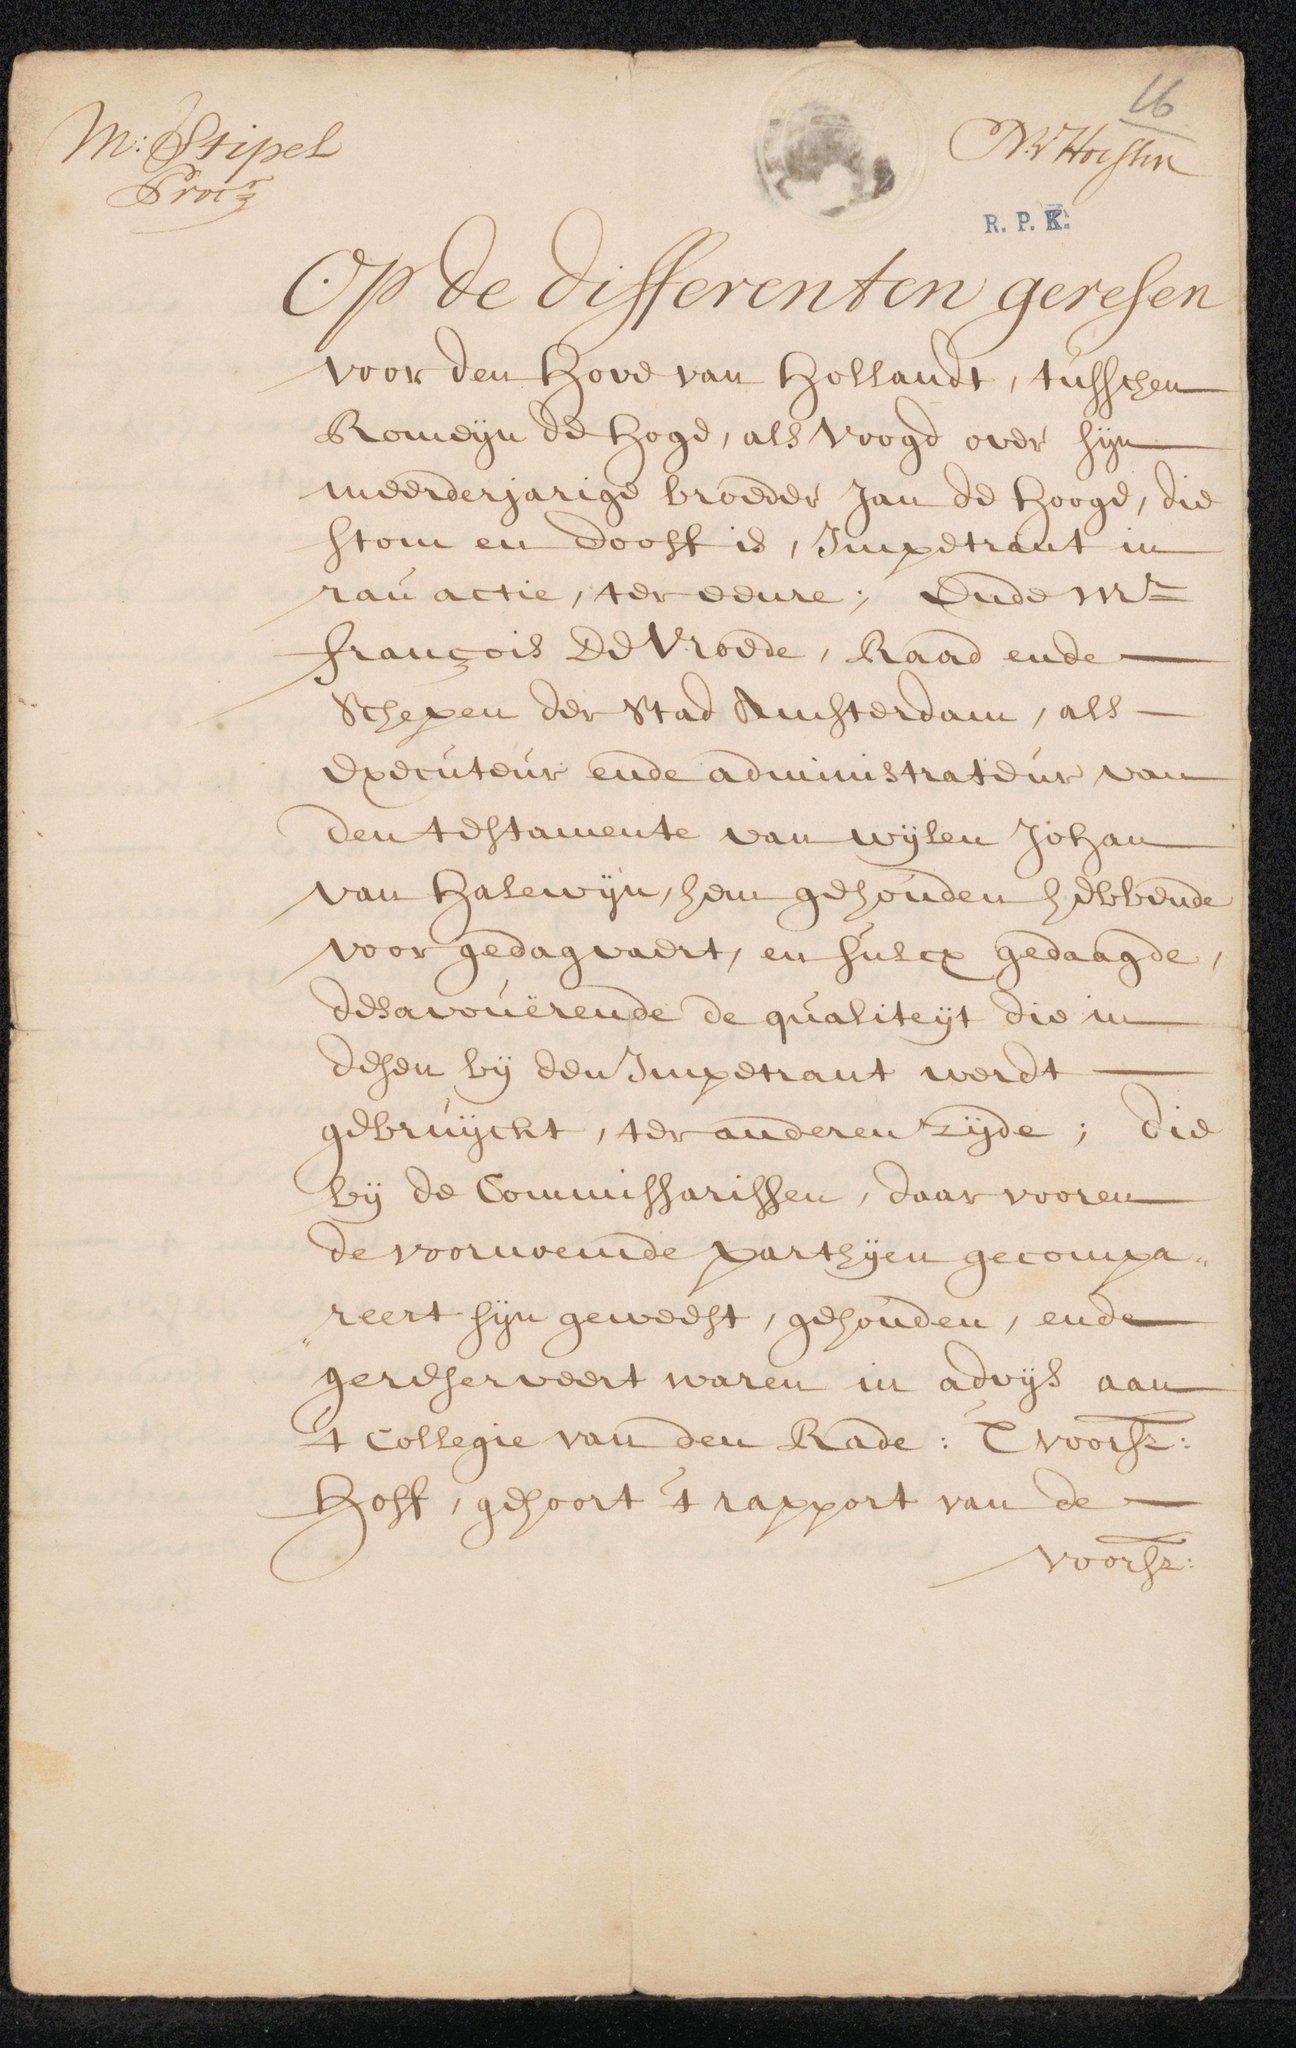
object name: manuscript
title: Gerechtelijke uitspraak met betrekking tot Johannes de Hooghe (1650-1731)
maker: Anonymous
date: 1695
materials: ink, paper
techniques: pen, writing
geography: the hague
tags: money, the hague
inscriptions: watermark, collector's mark: Lugt 2233, seal